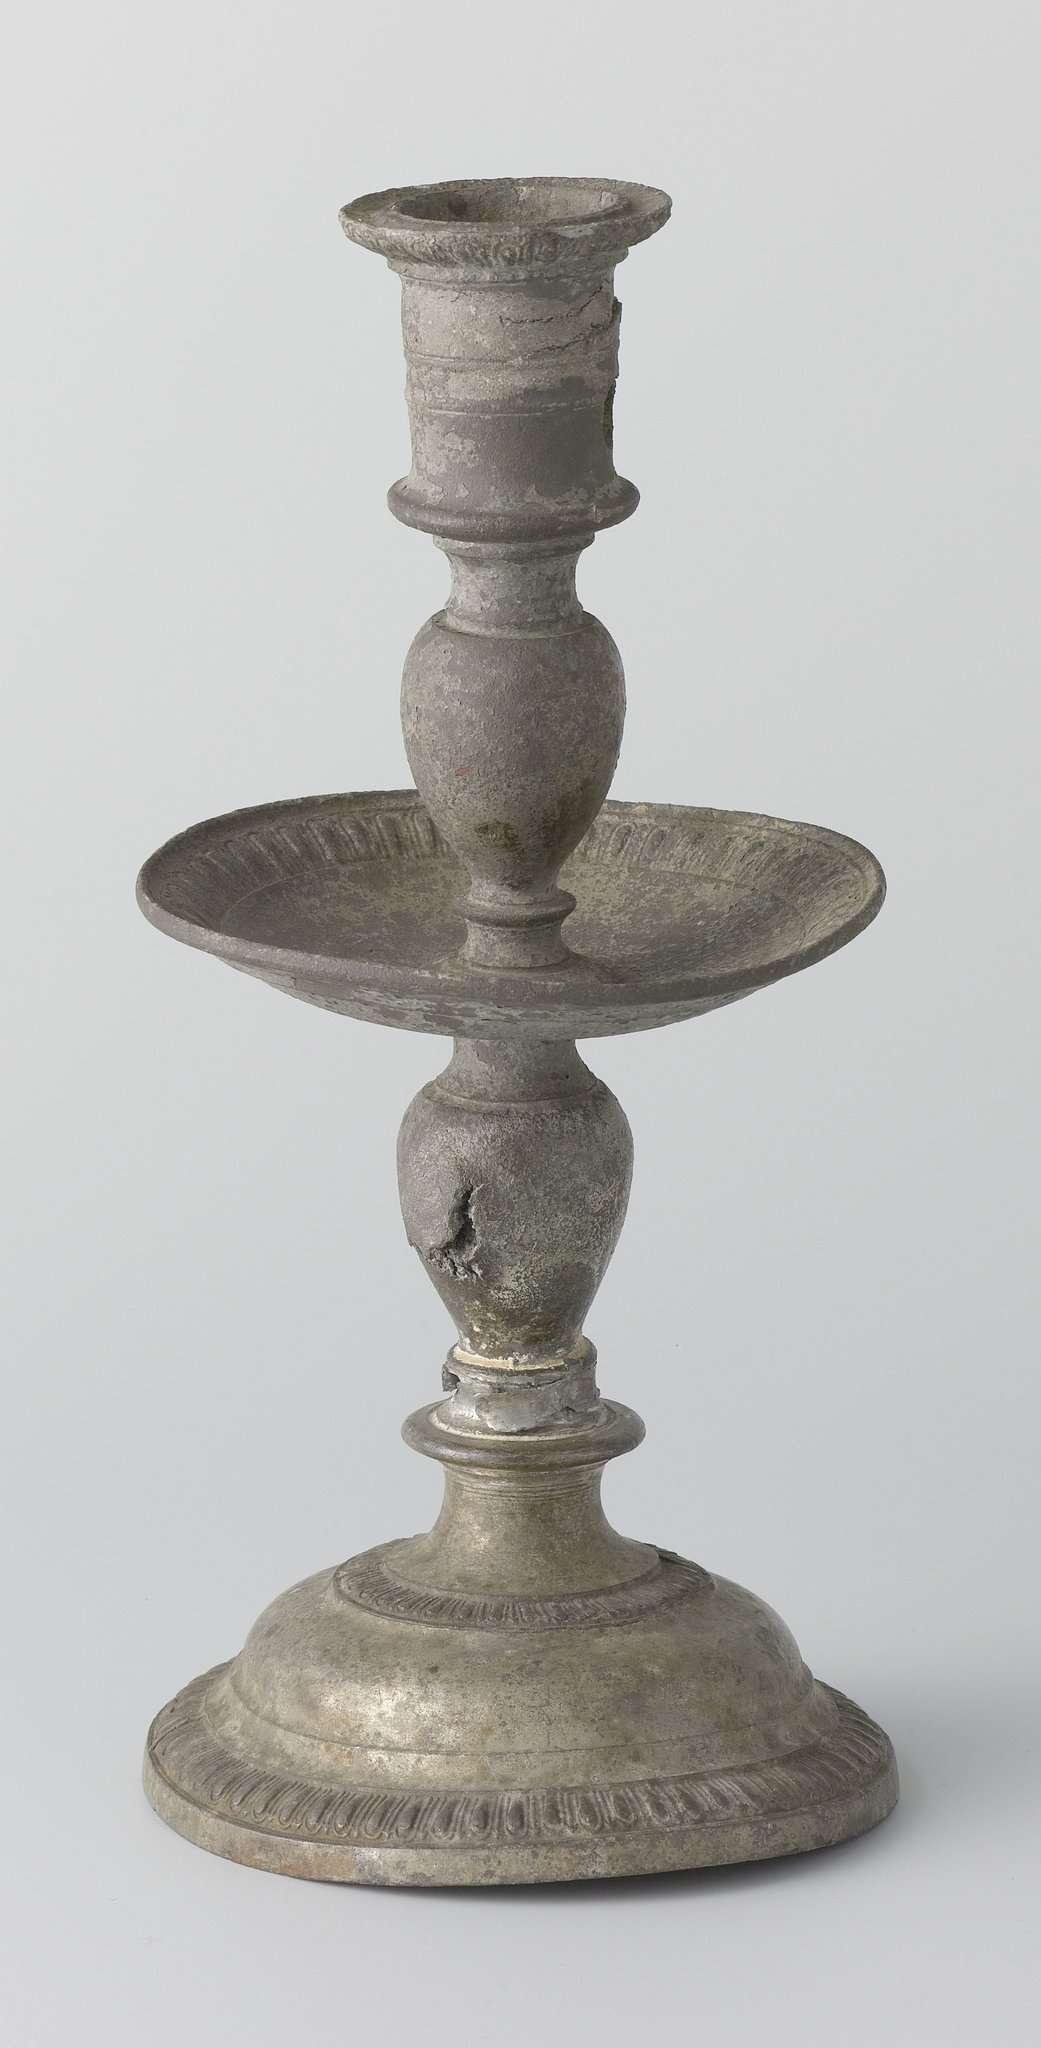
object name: taper holder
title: Kandelaar, vijfdelig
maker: Anonymous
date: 1590-1596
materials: tin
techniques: casting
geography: netherlands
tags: willem barendsz., amsterdam, jacob van heemskerck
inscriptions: mark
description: Kandelaar, vijfdelig met breed uitlopende cirkelvormig voet versierd met twee eierlijsten. De kandelaar heeft een balustervormige schacht of stam met aan onderkant schijfvormige knoop, een concave vetschaal met eierlijst en een balustervormige schacht. De kaarsenhouder is cylindrisch met twee ronde lekgaten en aan bovenkant eierlijst. De gietnaden zijn over de eierlijsten zichtbaar.